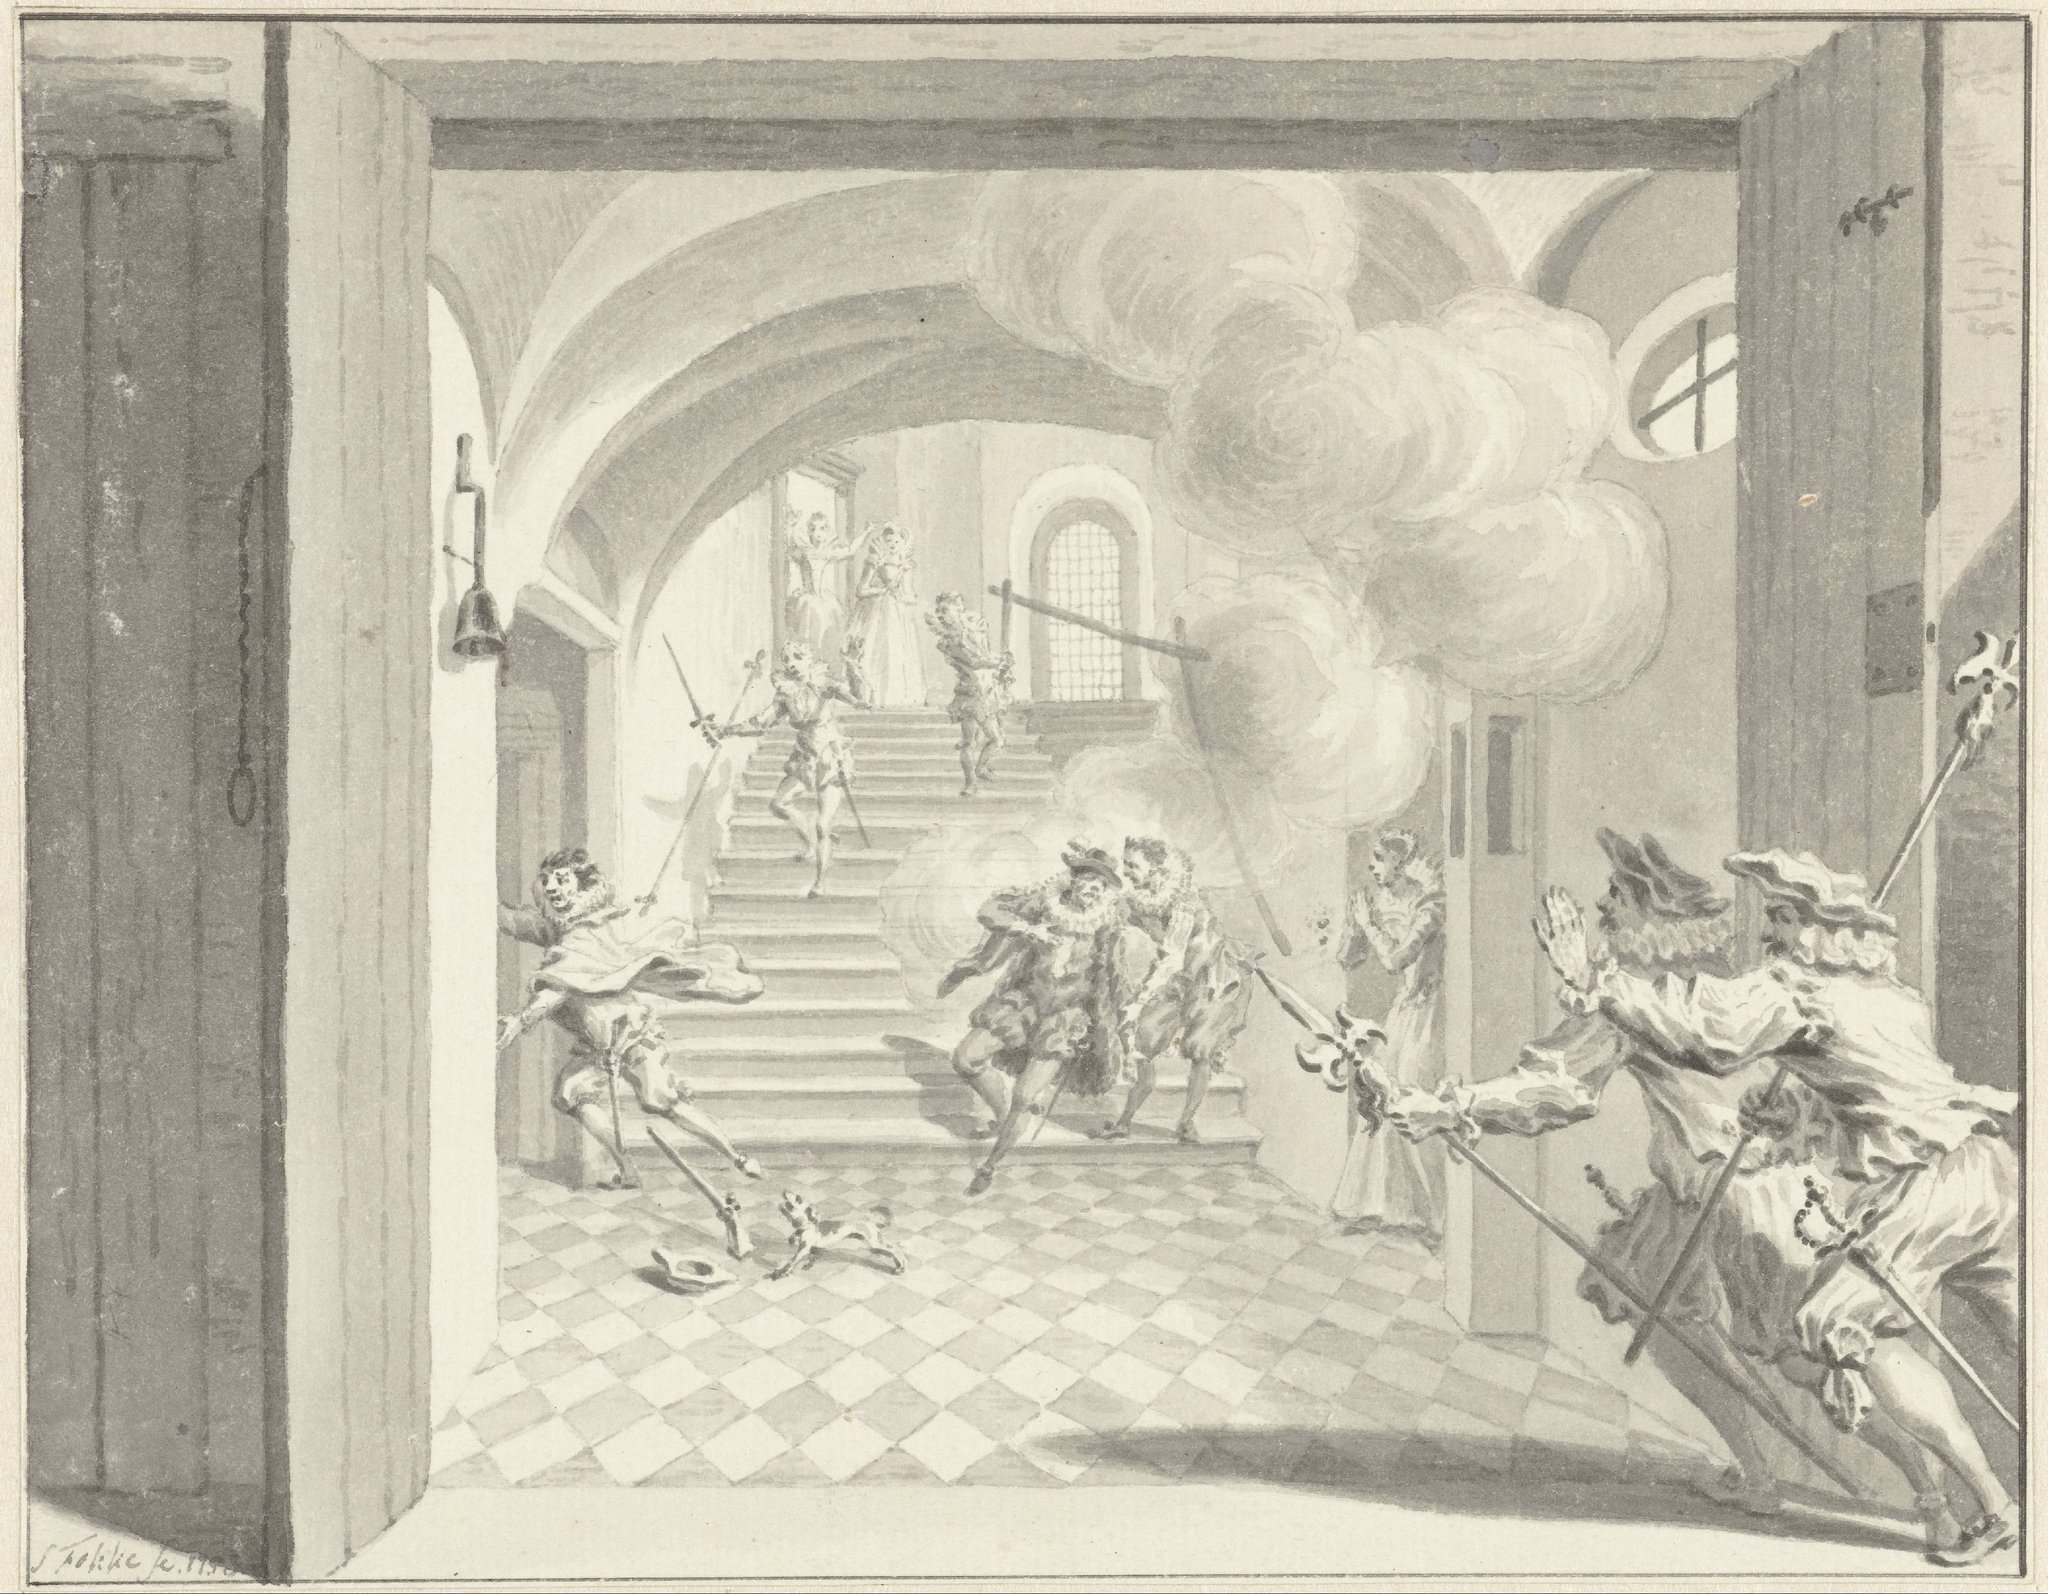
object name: drawing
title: Willem I door Balthasar Gerards vermoord, Delft 10 juli 1584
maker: simon fokke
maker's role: draughtsman, print maker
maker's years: 1712-1784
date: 1753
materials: ink, paper, pencil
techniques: brush, pen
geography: amsterdam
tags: delft, william i (prince of orange), violent death ~ elements, historical persons, attempt, political murder, historical events and situations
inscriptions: date: ‘1753’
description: Prent waar deze tekening naar is gemaakt ook gebruikt in: Wagenaar, Jan. Vaderlandsche historie, vervattende de geschiedenissen der Vereenigde Nederlanden […]. 21 delen. Amsterdam: Isaak Tirion, 1749-1759, dl. 7 (1752).